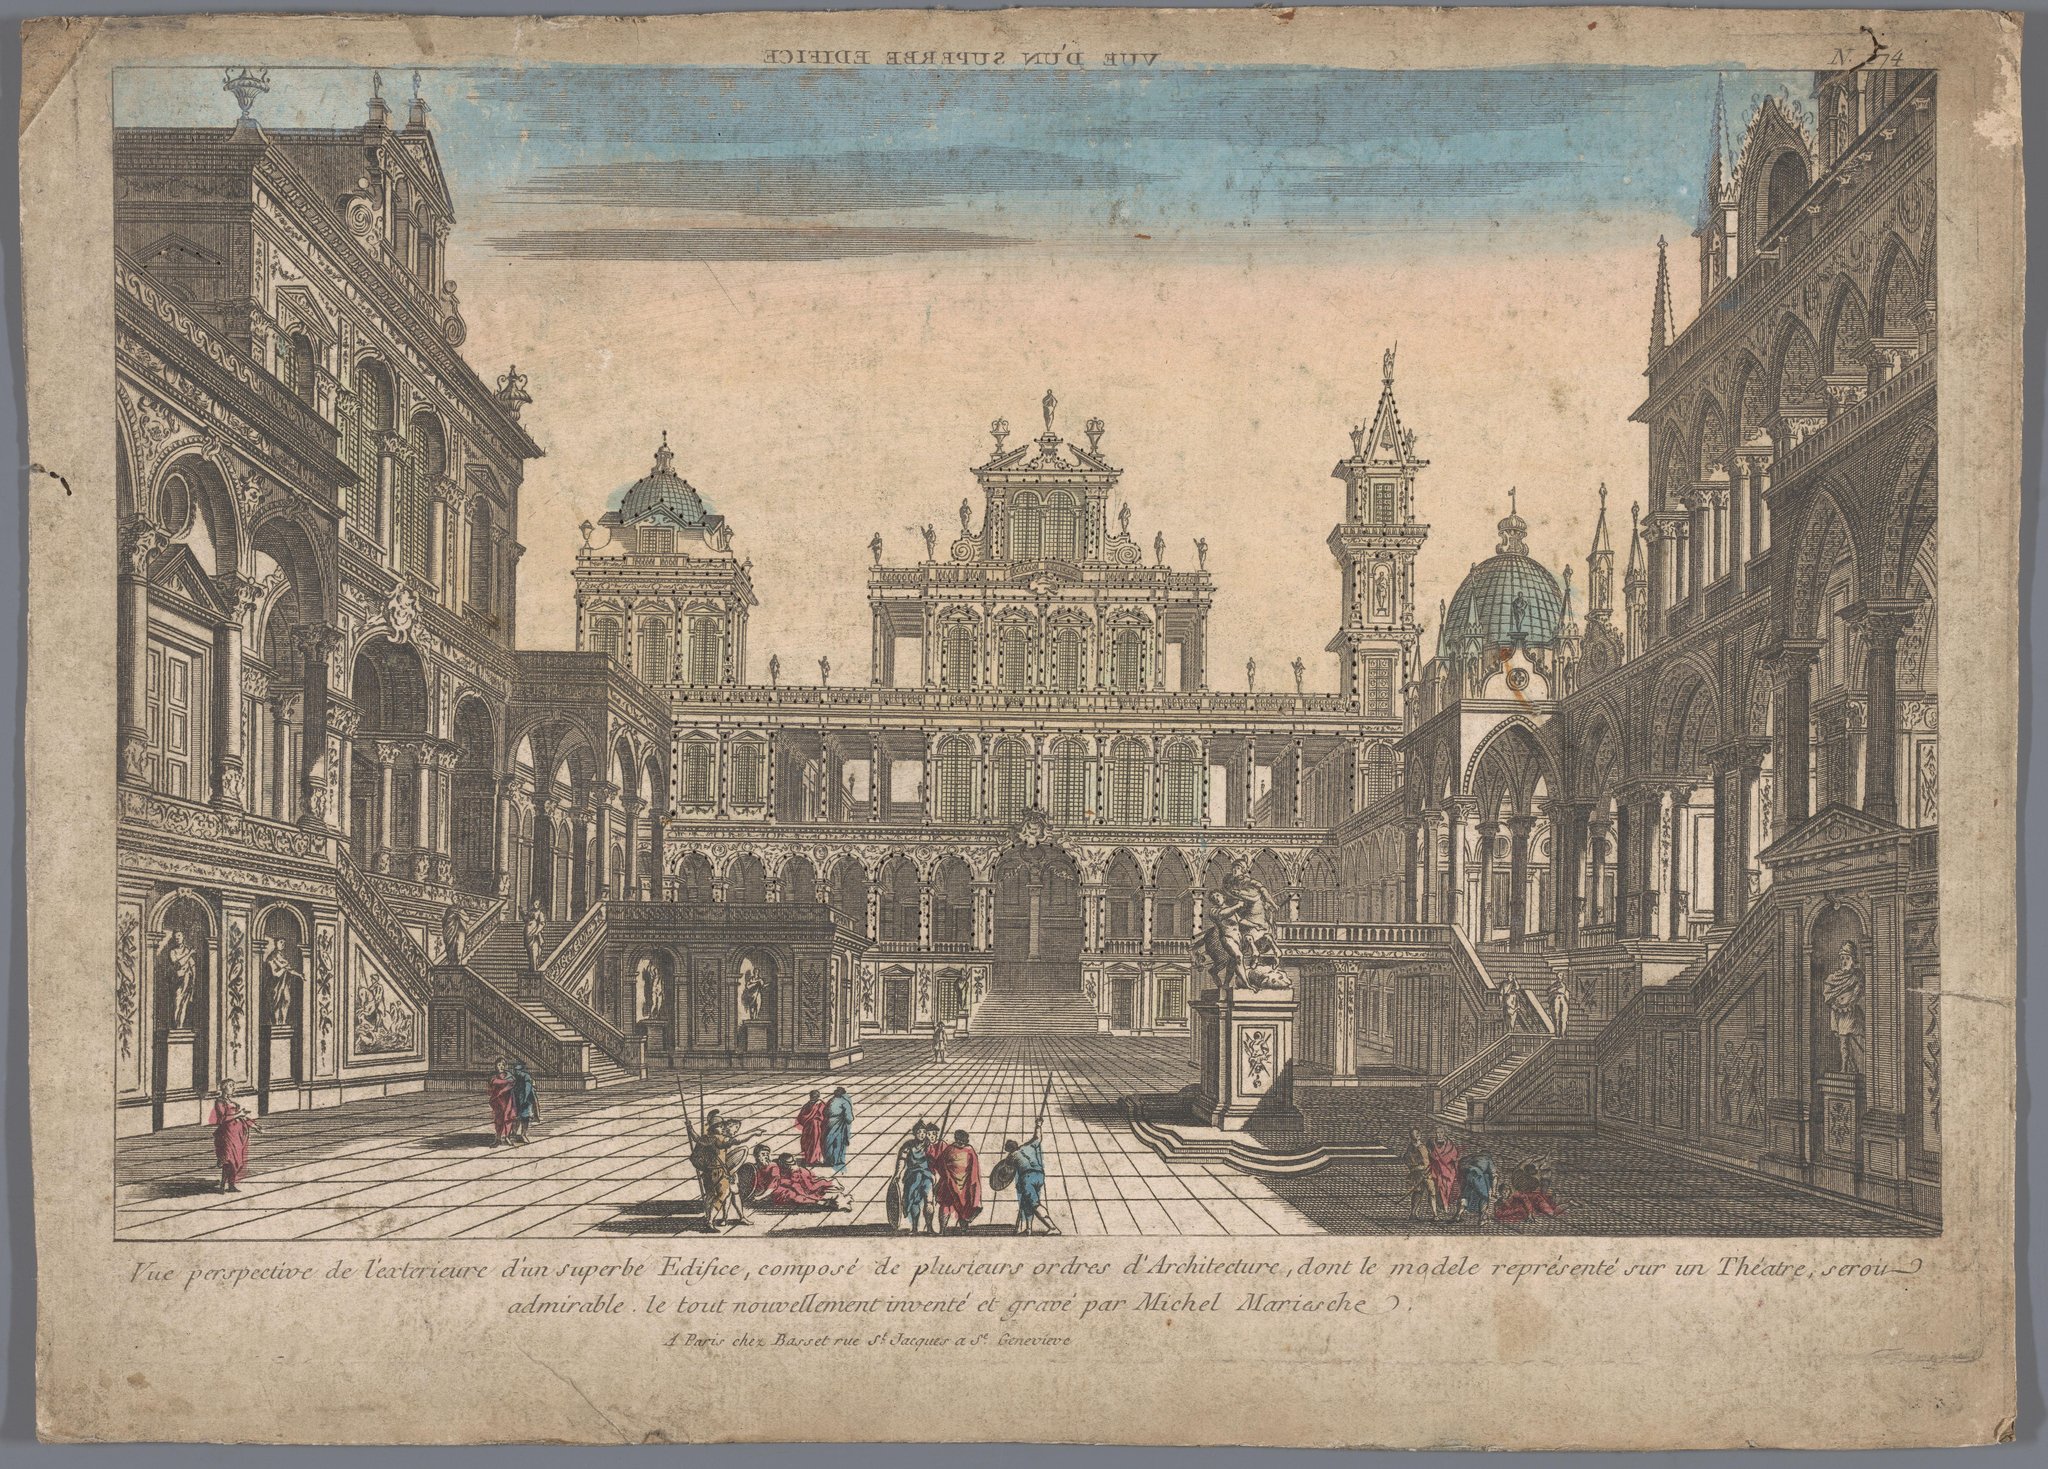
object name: print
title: Vue d'un superbe edifice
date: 1700-1799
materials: cardboard, paper, watercolor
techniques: brush, cutting, etching, perforating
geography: paris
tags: courtyard, civic architecture; edifices; dwellings